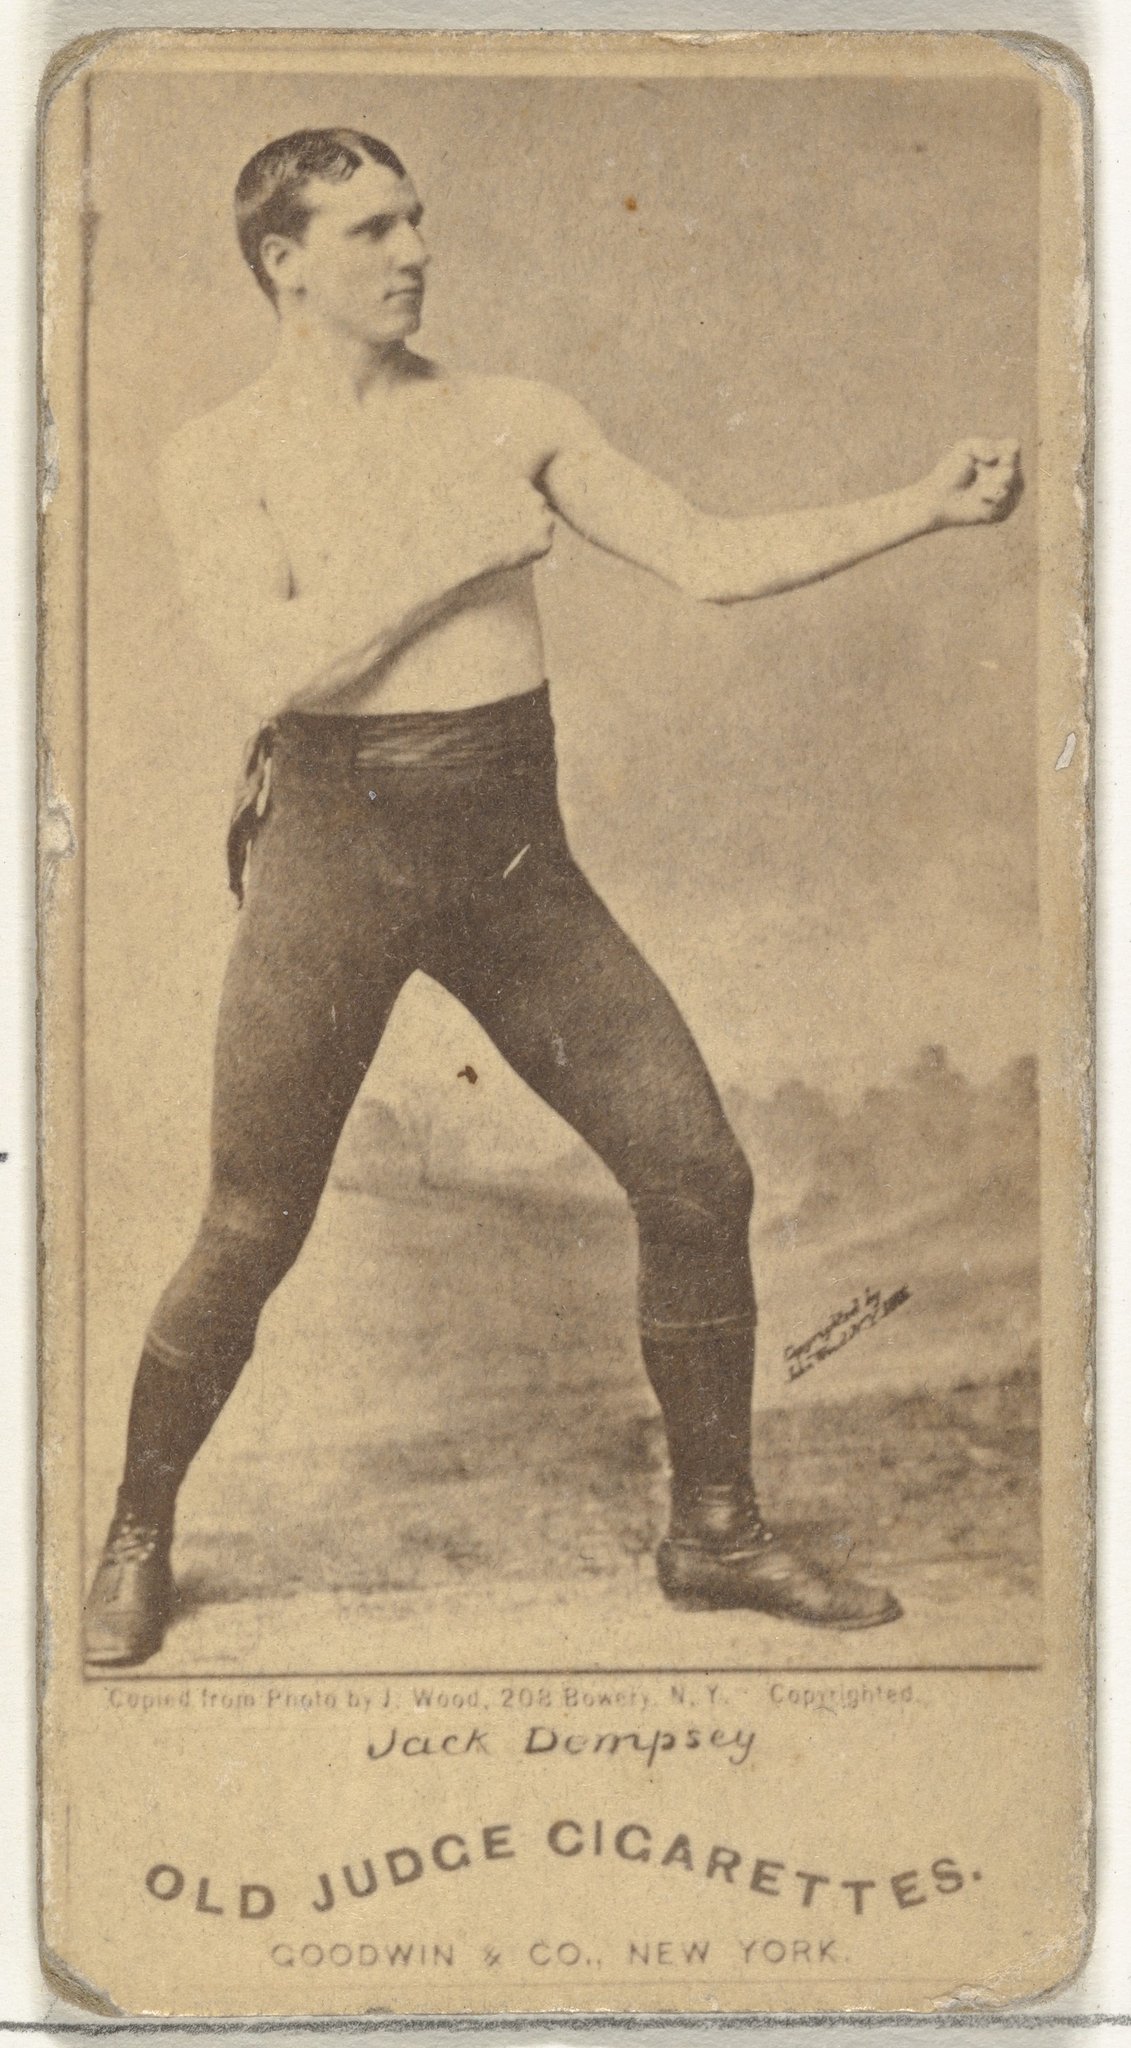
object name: photograph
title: Jack Dempsey, from the Celebrities and Prizefighters series (N174) for Old Judge Cigarettes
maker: goodwin & company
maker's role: publisher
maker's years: 1850-1950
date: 1887-1888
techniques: albumen silver print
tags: men,portraits,baseball,athletes